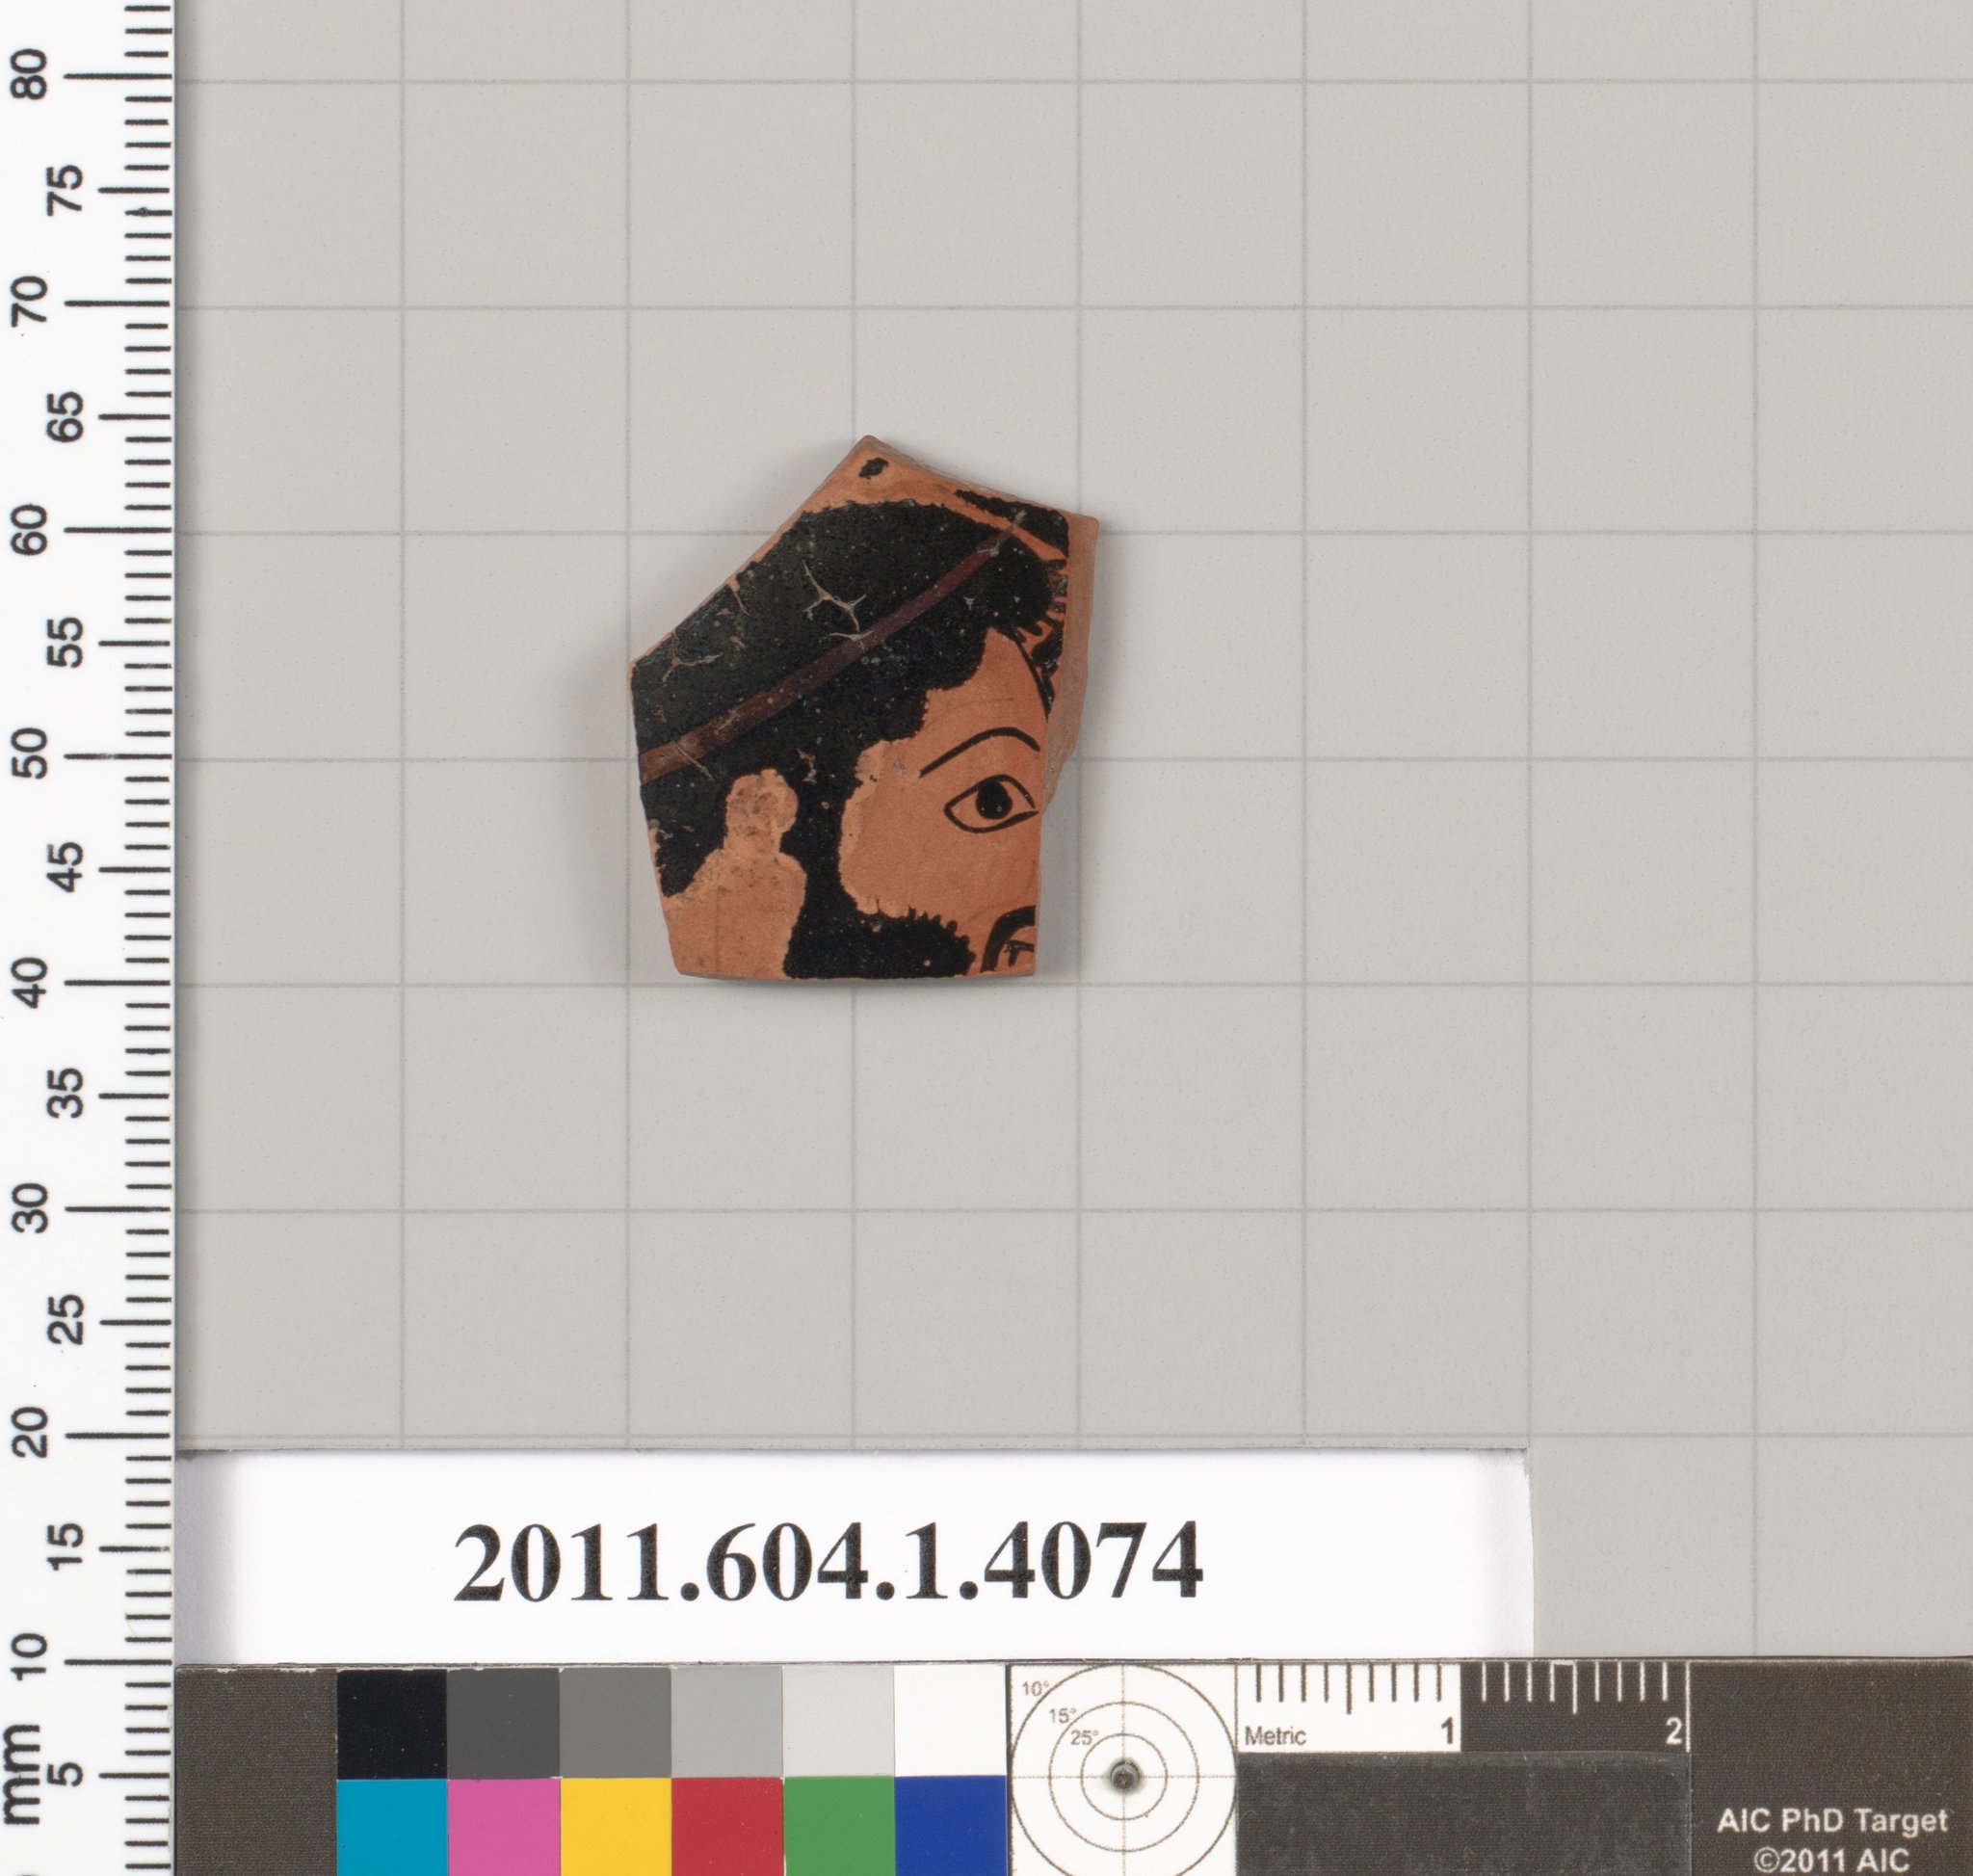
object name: kylix fragment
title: Terracotta fragment of a kylix (drinking cup)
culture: greek, attic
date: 520-500 BCE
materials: terracotta